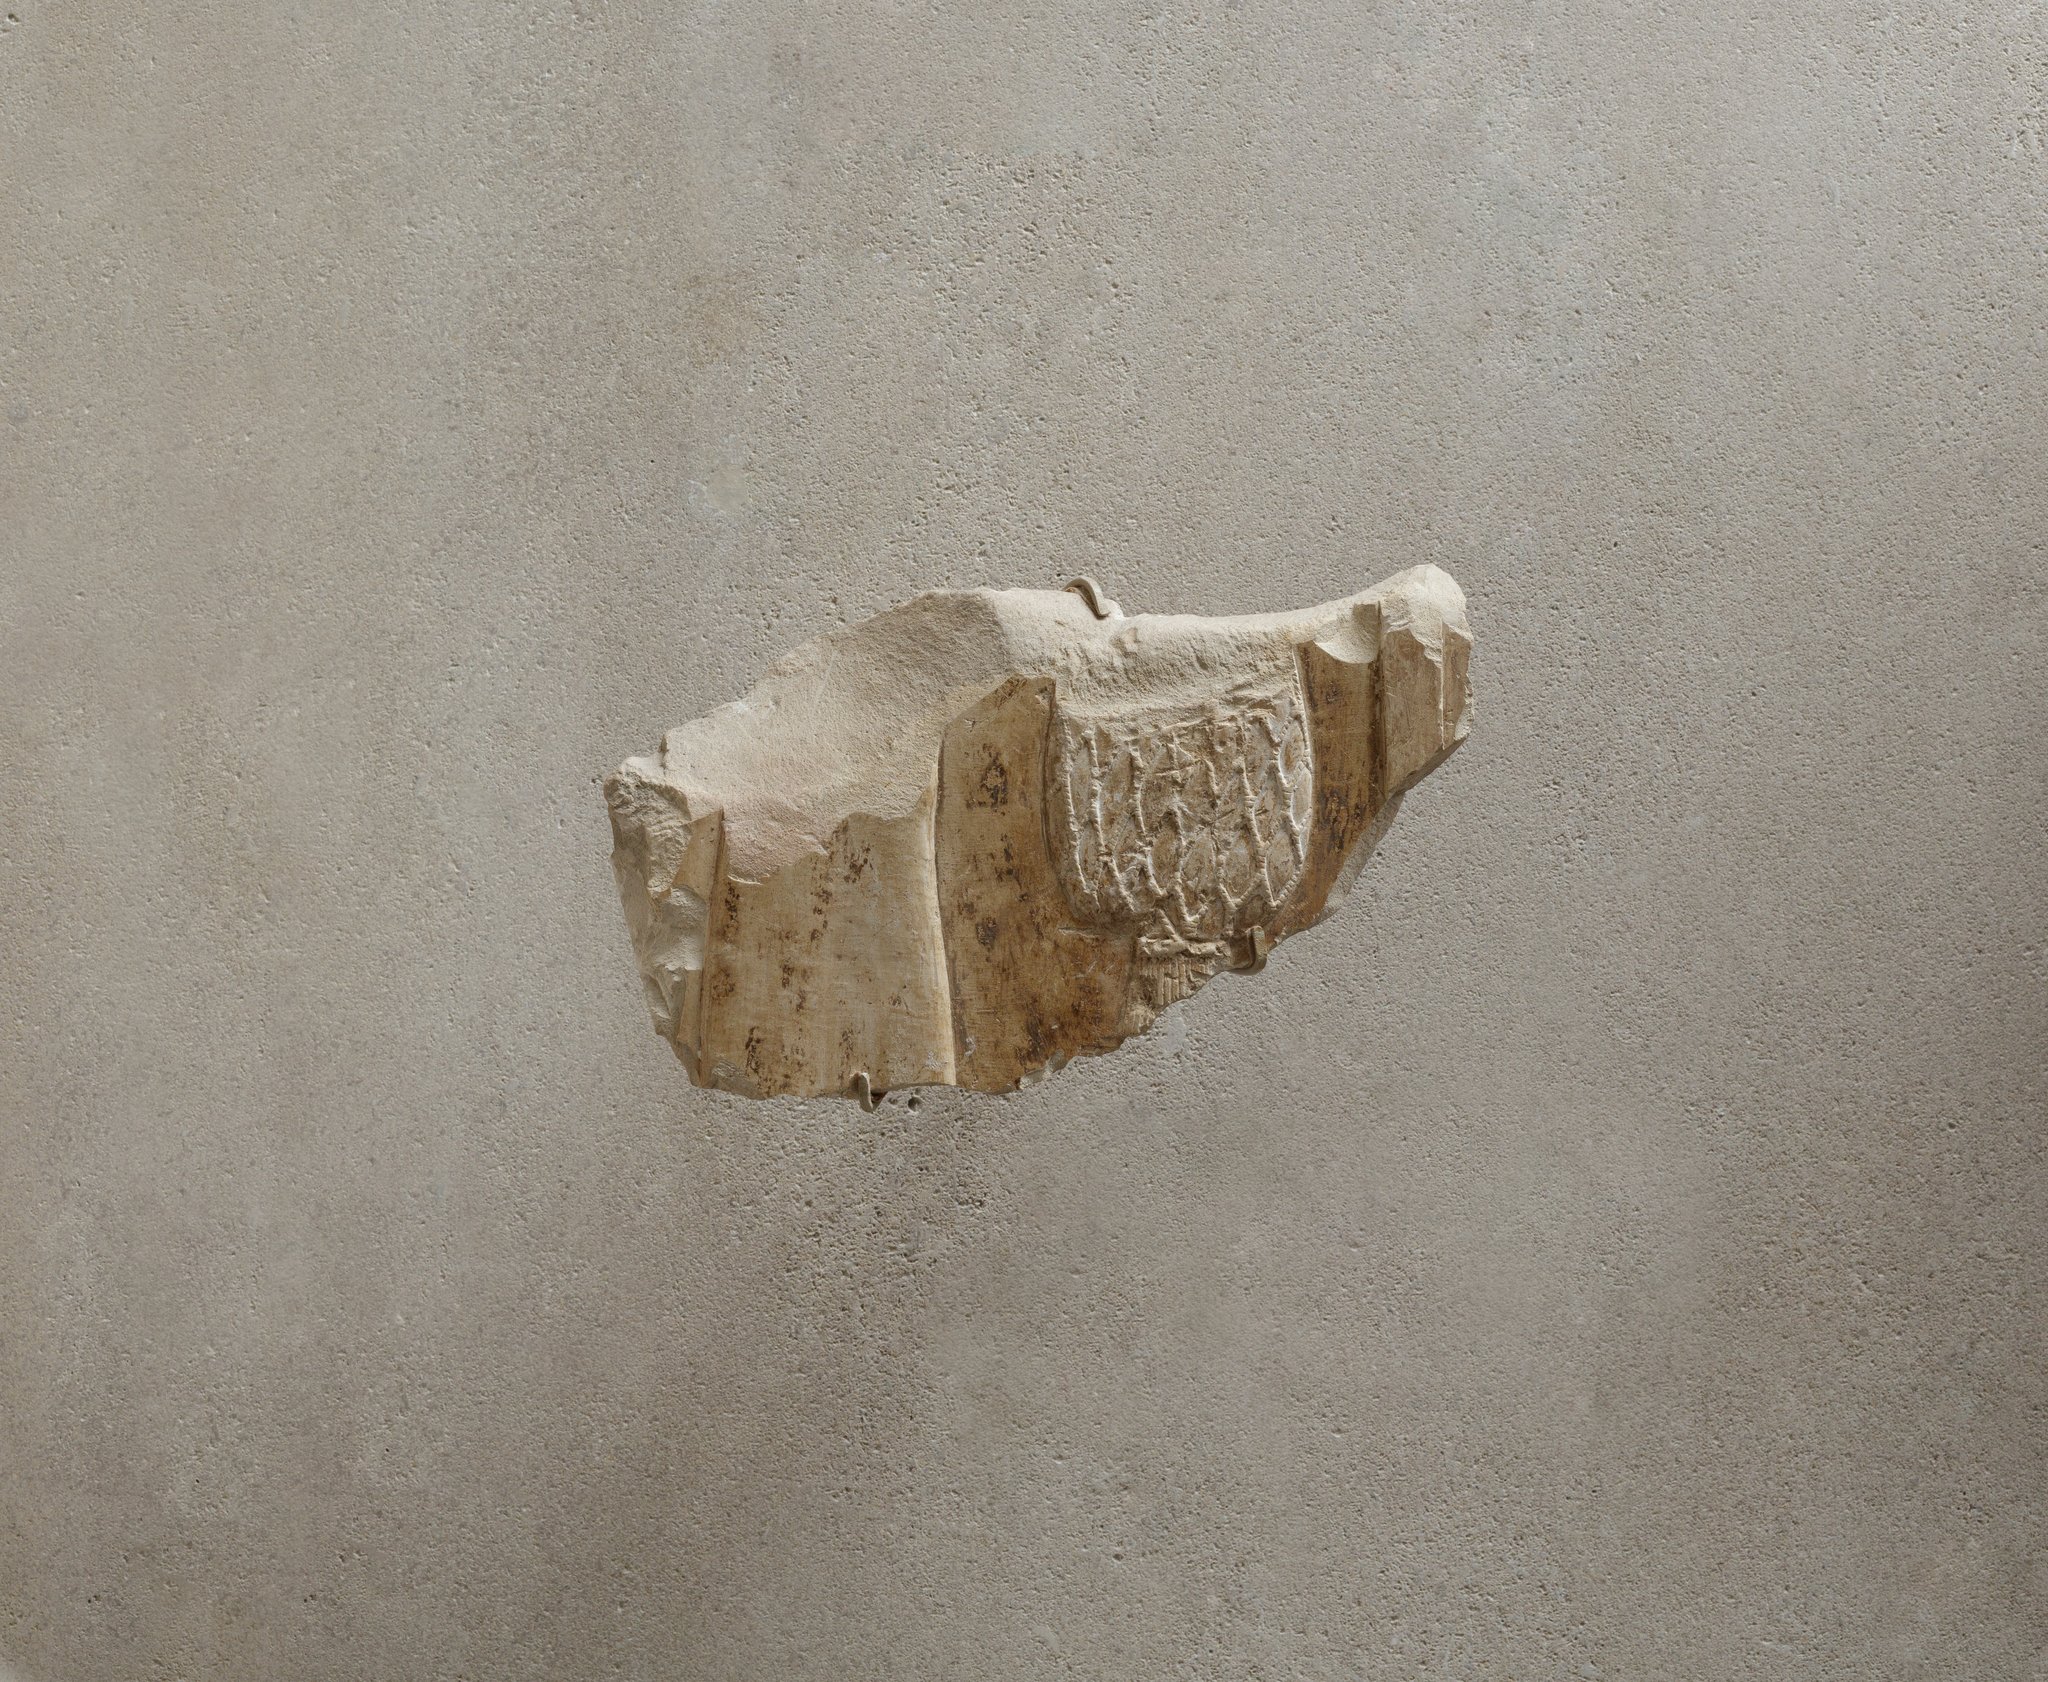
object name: relief, perfume press, neferu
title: Relief fragment of a perfume press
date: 2051-2030 BCE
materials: limestone, paint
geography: egypt